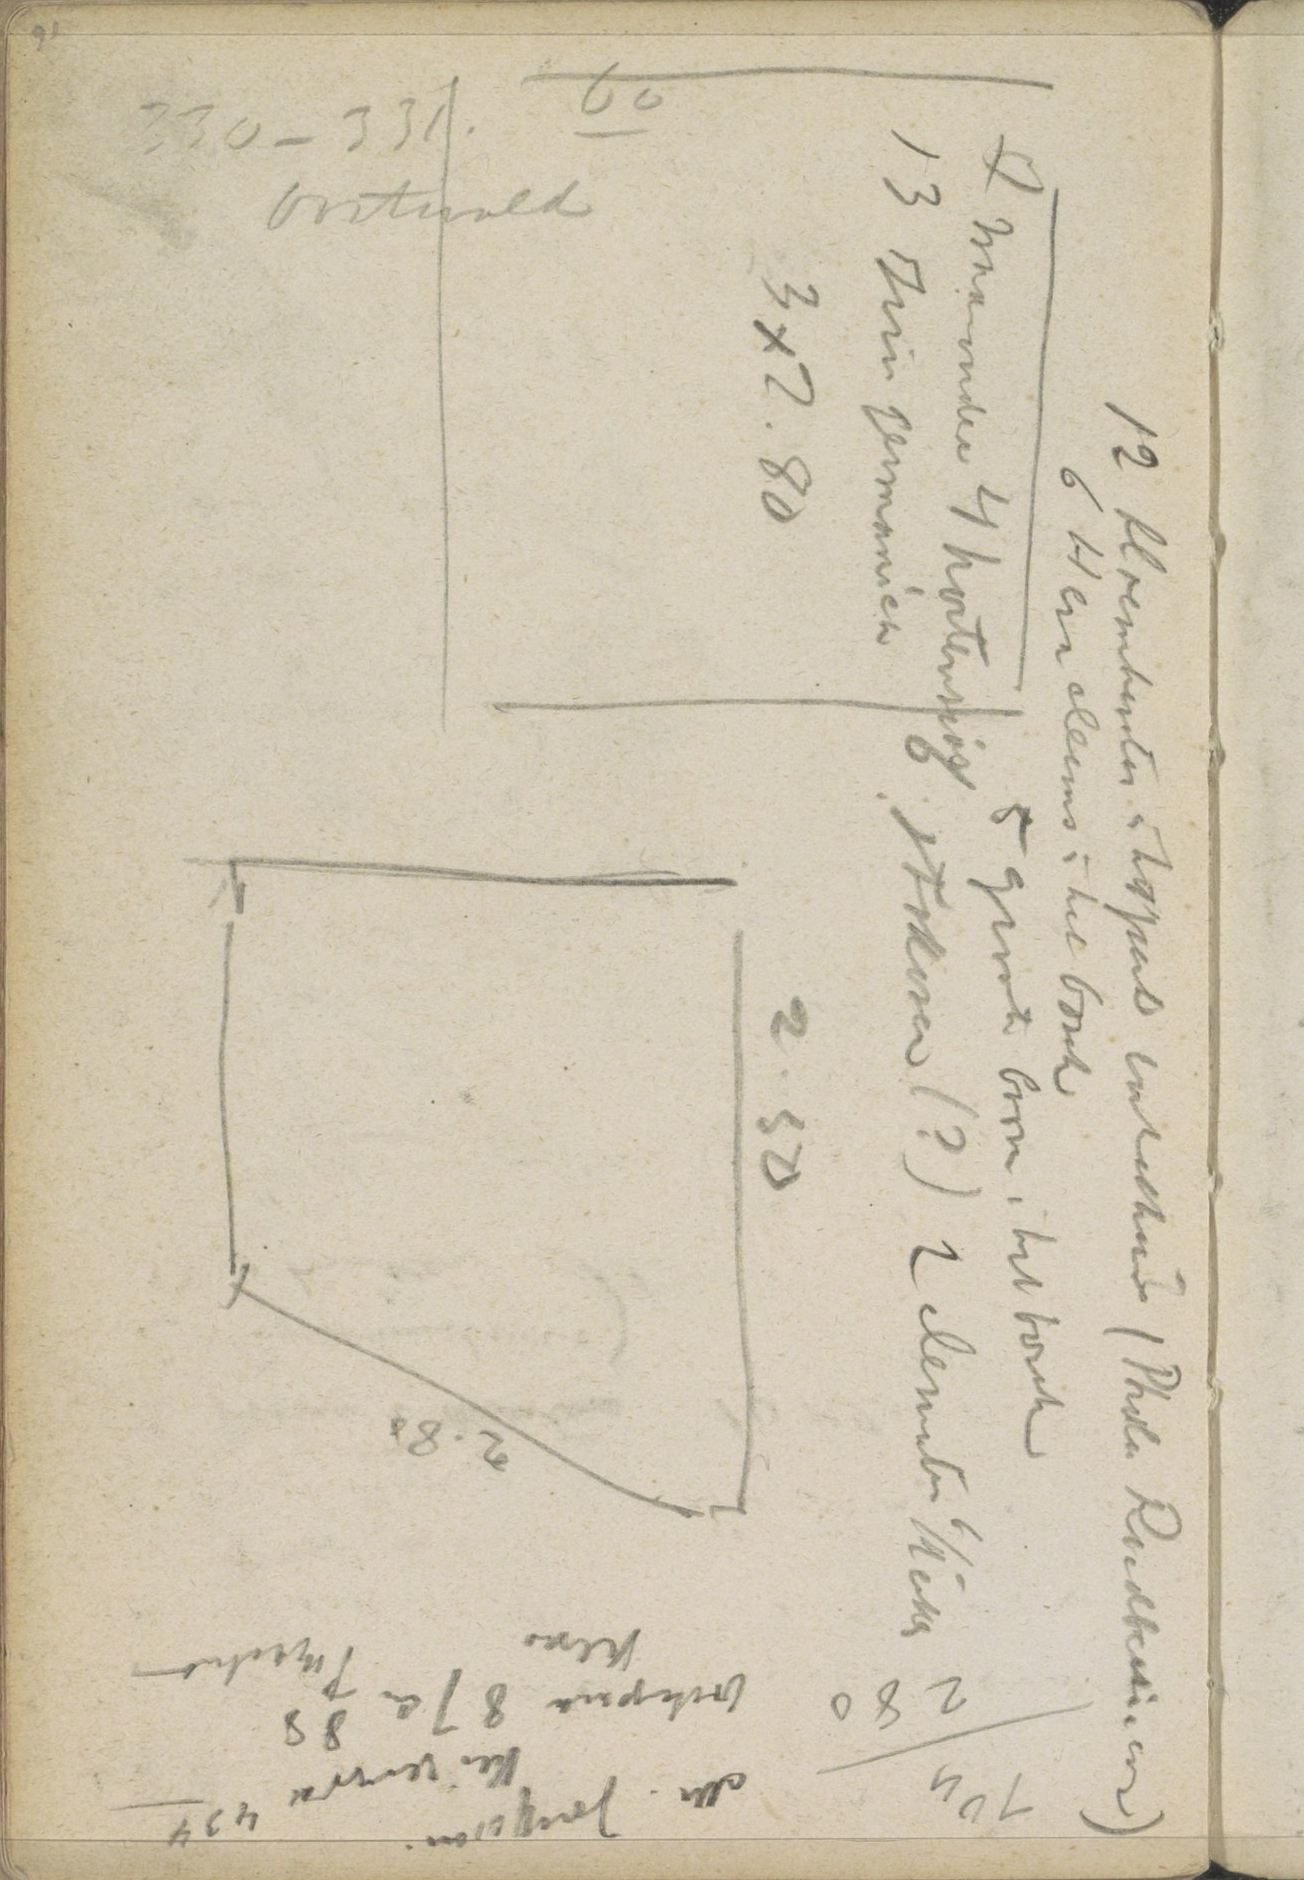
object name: sketchbook leaf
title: Annotaties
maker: george hendrik breitner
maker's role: draughtsman, painter, print maker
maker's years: 1857-1923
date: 1886-1908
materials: paper, pencil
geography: amsterdam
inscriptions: size, annotation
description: Pagina 91 uit een schetsboek met 46 bladen vervaardigd te Amsterdam, Haarlem en Antwerpen.